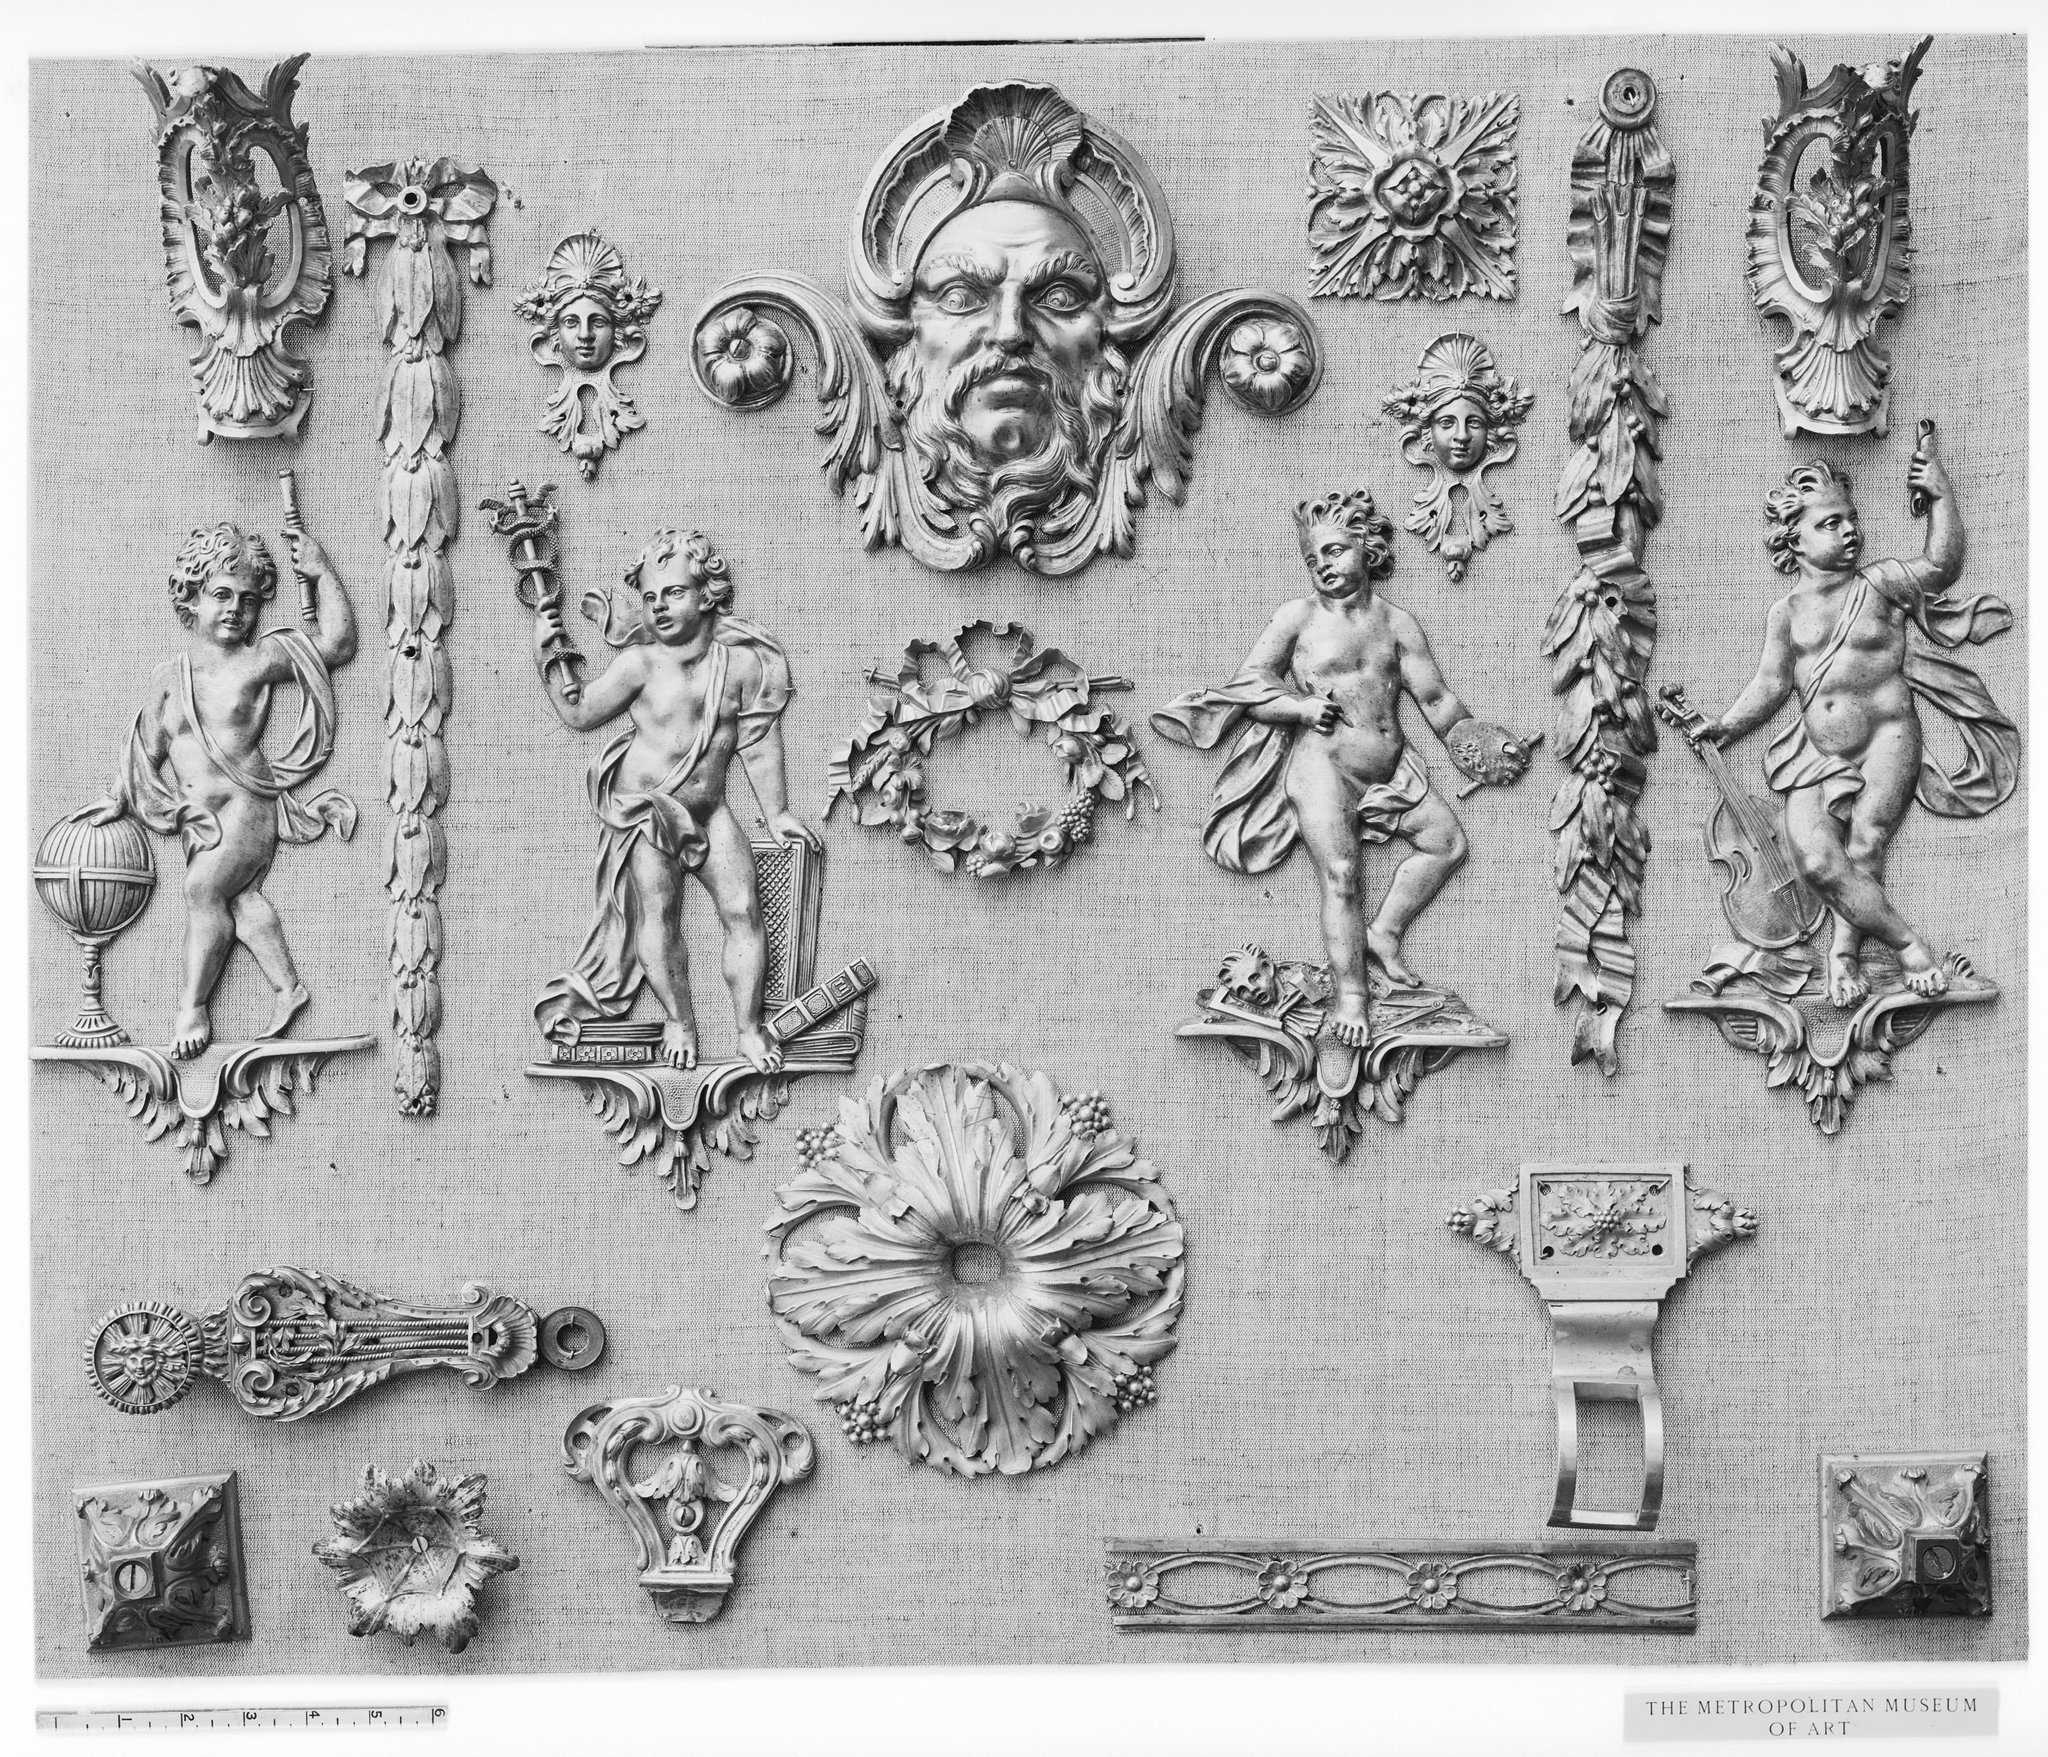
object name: panel ornament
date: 1701-1800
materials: gilt bronze